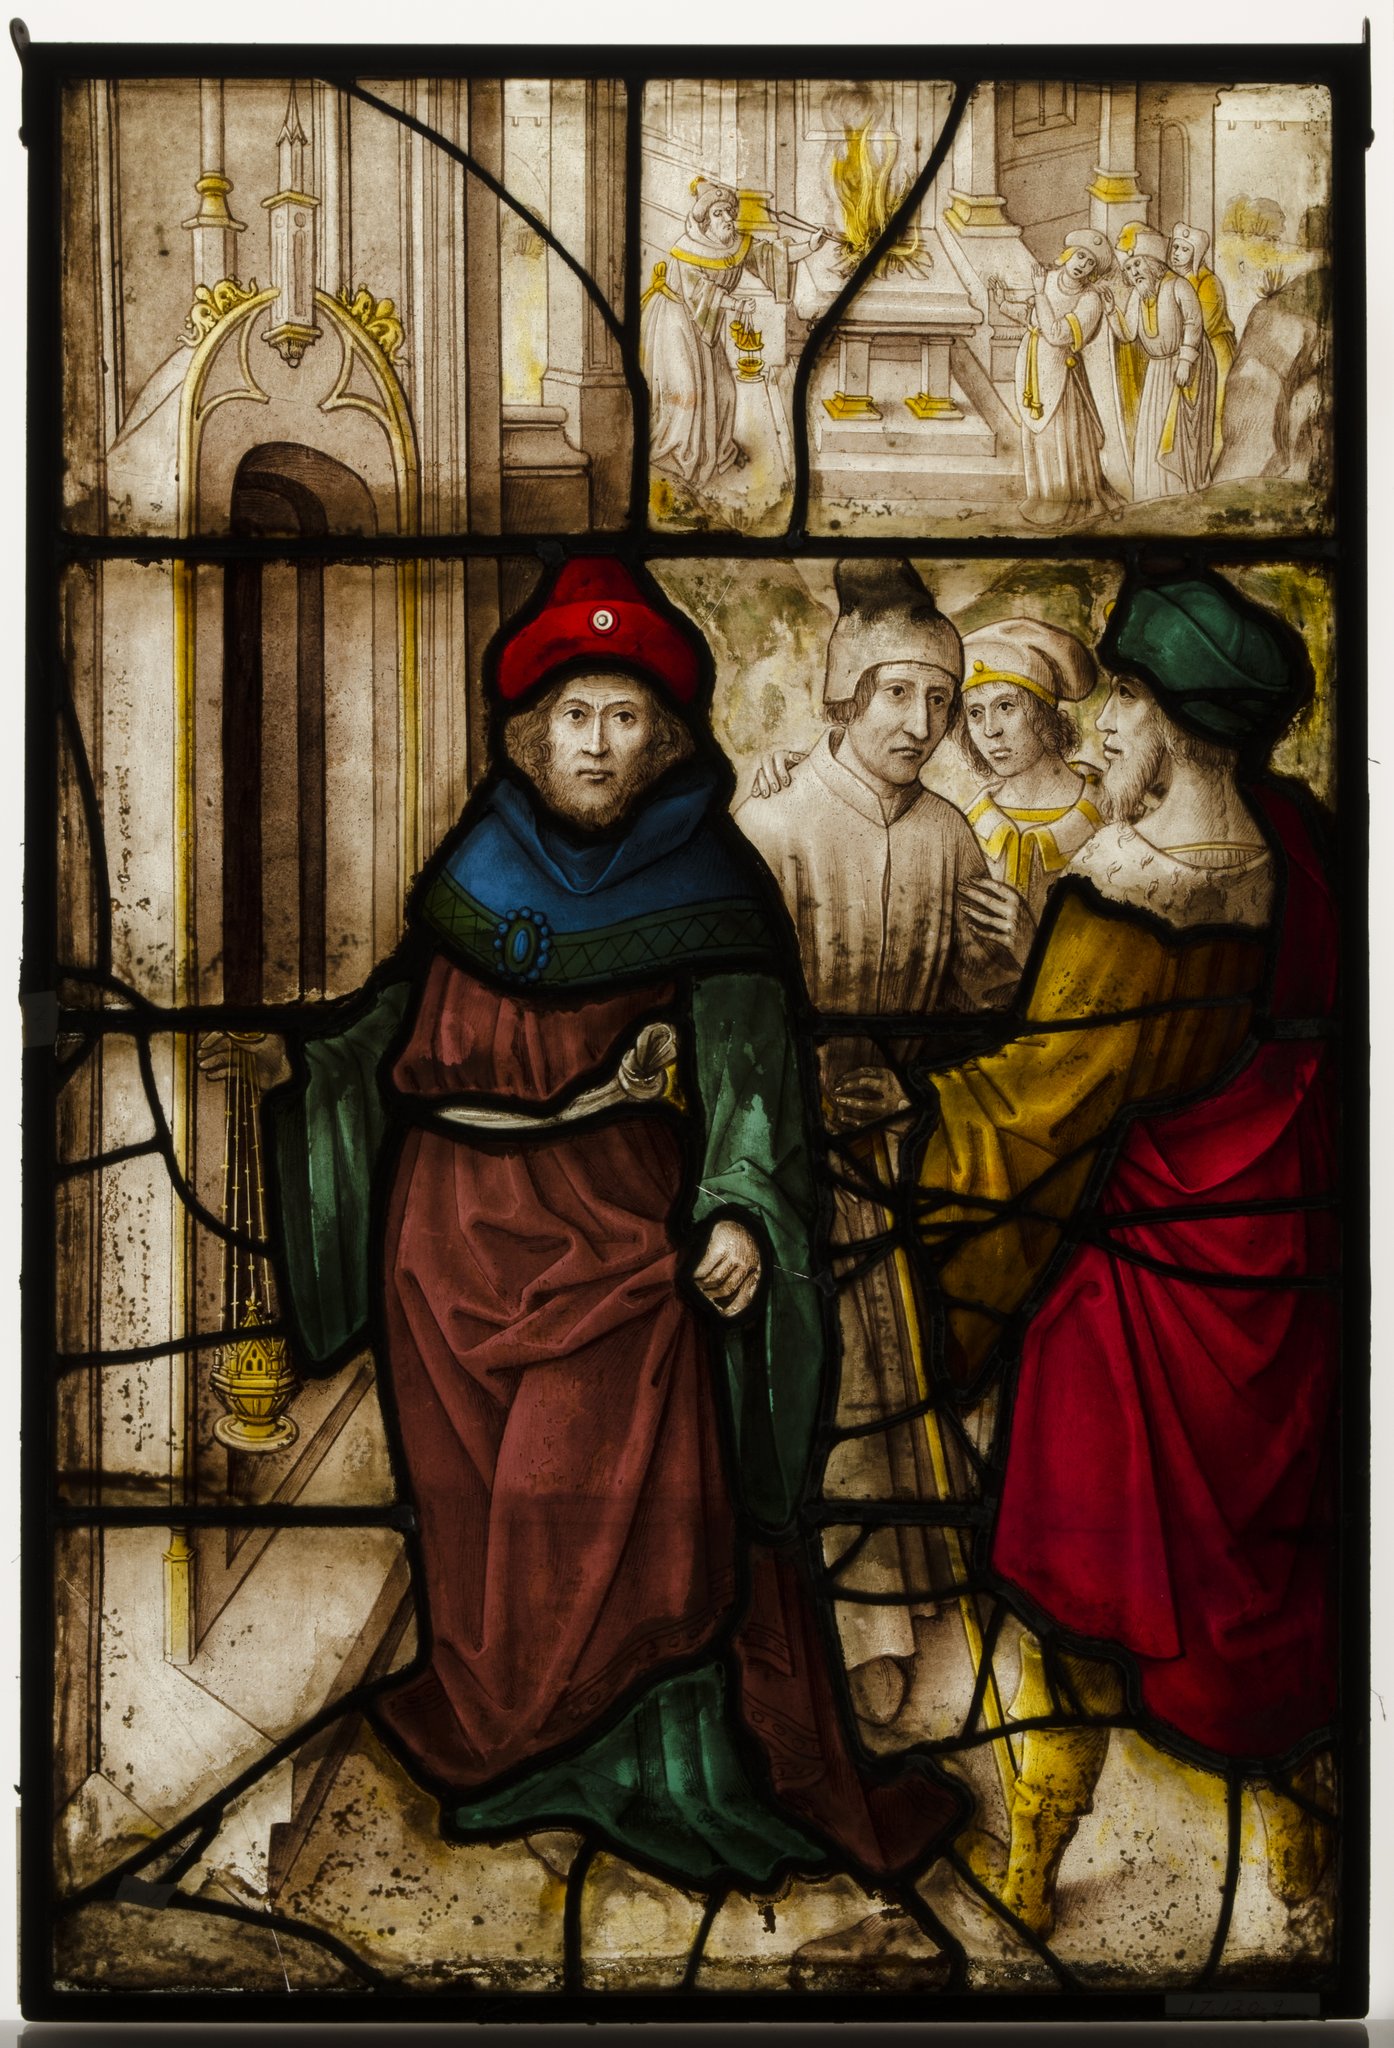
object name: panel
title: Glass Panel with Profanation of Jerusalem and the Sacred Rites of The Temple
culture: german or south netherlandish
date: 1501-1600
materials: glass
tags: temples